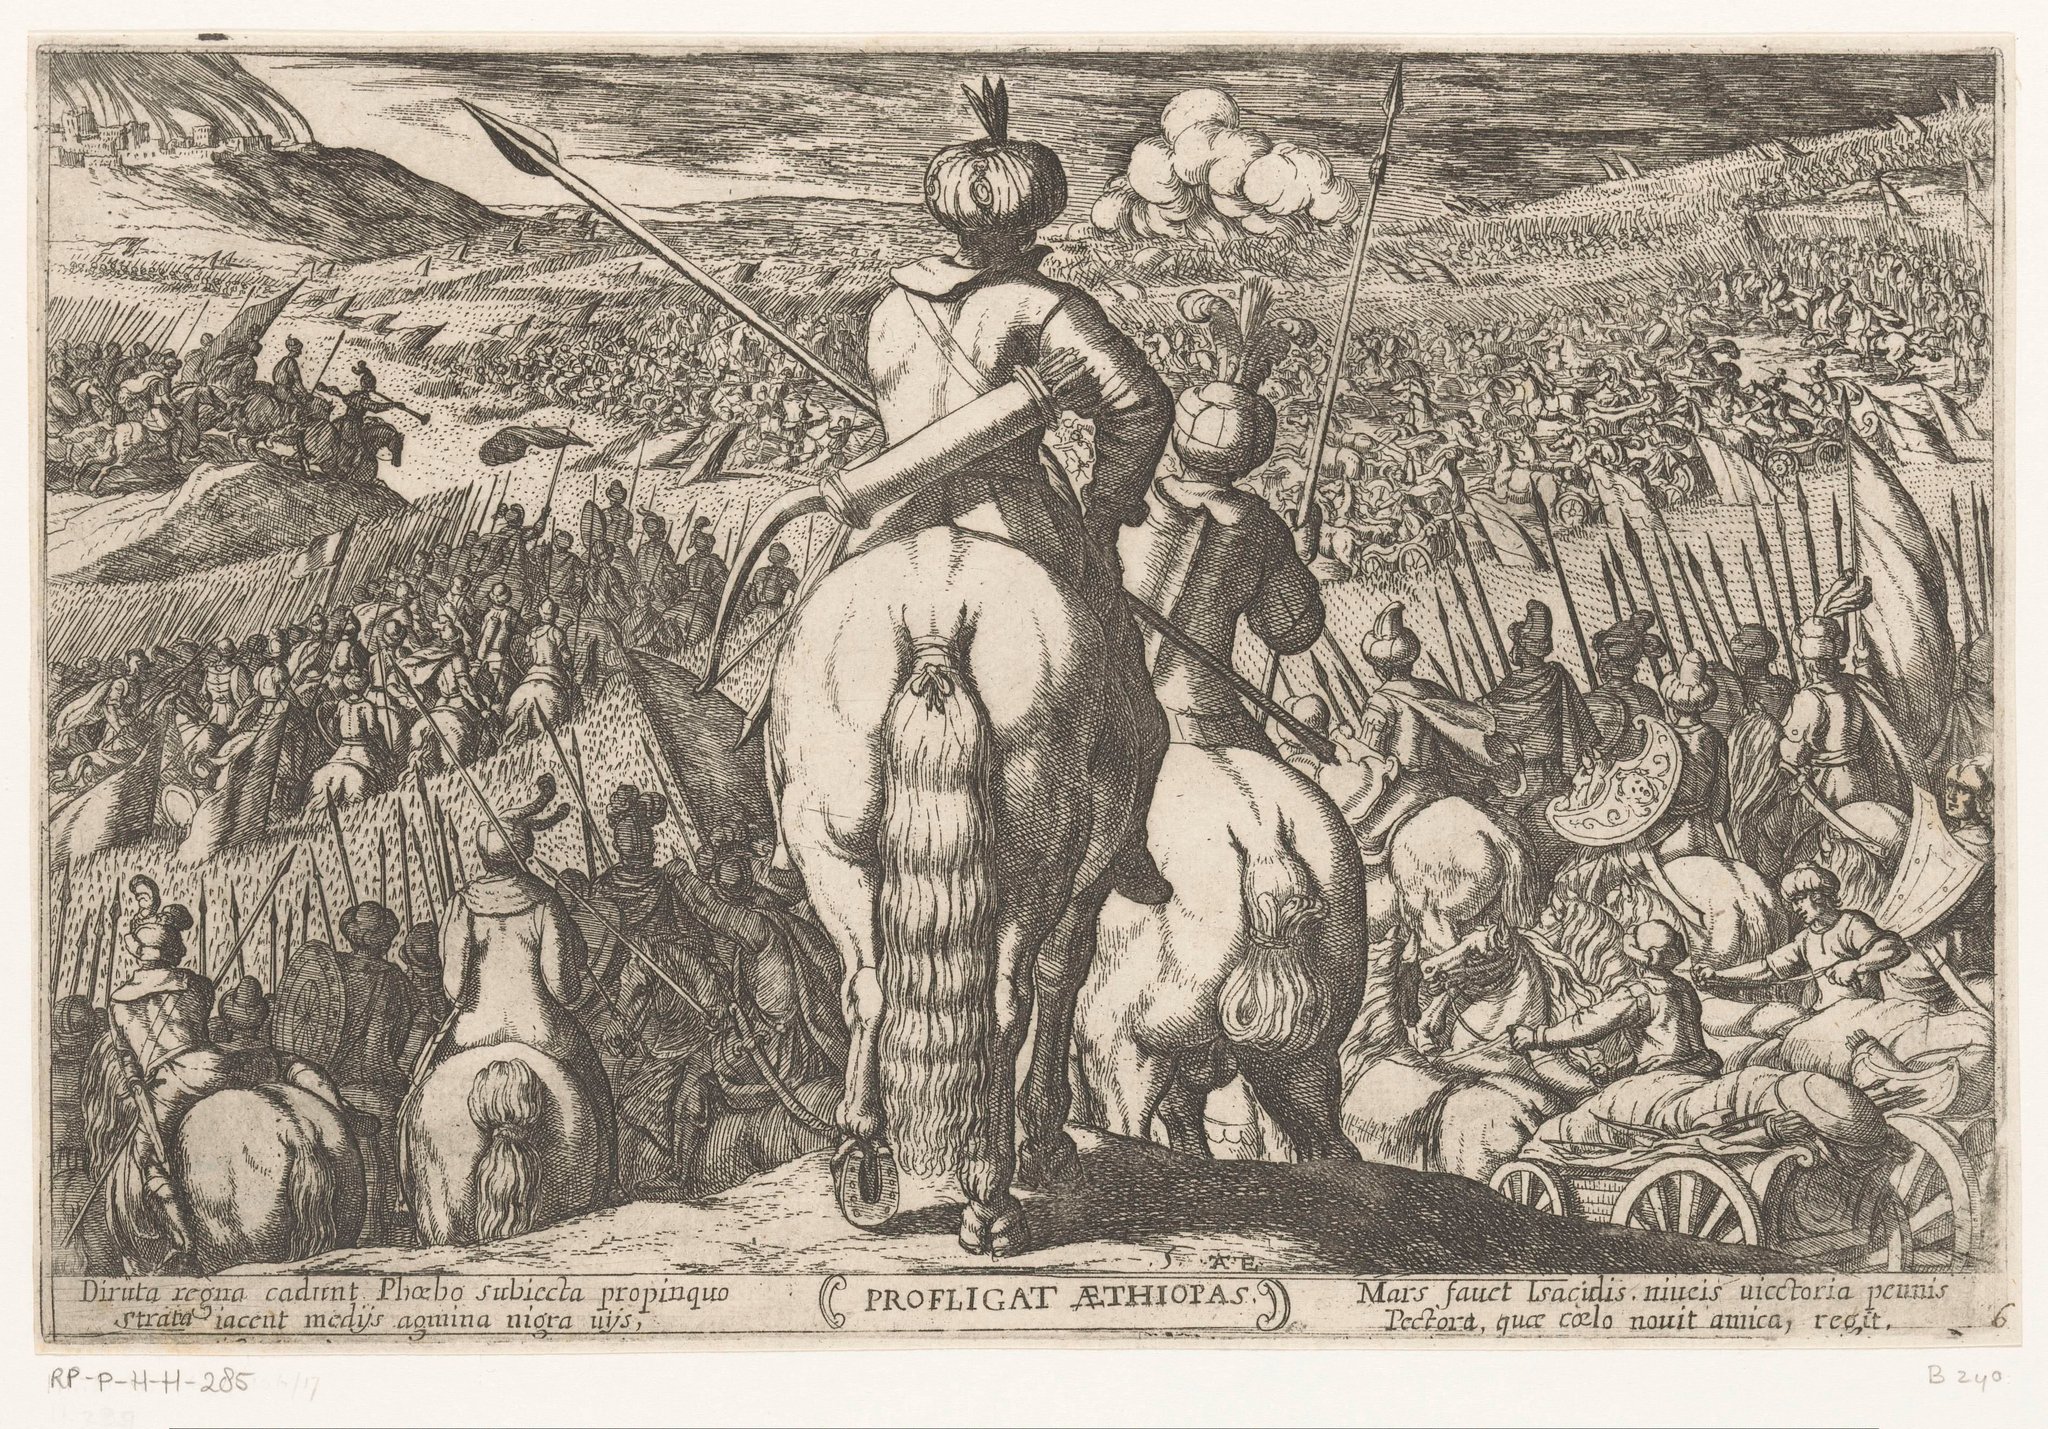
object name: print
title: Profligat Aethiopas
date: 1613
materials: paper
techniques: etching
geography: rome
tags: battle, warfare; military affairs (+ cavalry, horsemen), the soldier; the soldier's life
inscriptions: number: ‘6’, collector's mark: ‘Hinloopen’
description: Mozes en zijn leger verslaan de Ethiopiërs. Mozes zit te paard, op de rug gezien, en kijkt uit over het dal waar de strijd aan de gang is. Titel en onderschrift in het Latijn in de ondermarge. Oorspronkelijk genummerd 5 in voorstelling naast monogram van Tempesta, maar hier weggekrast.